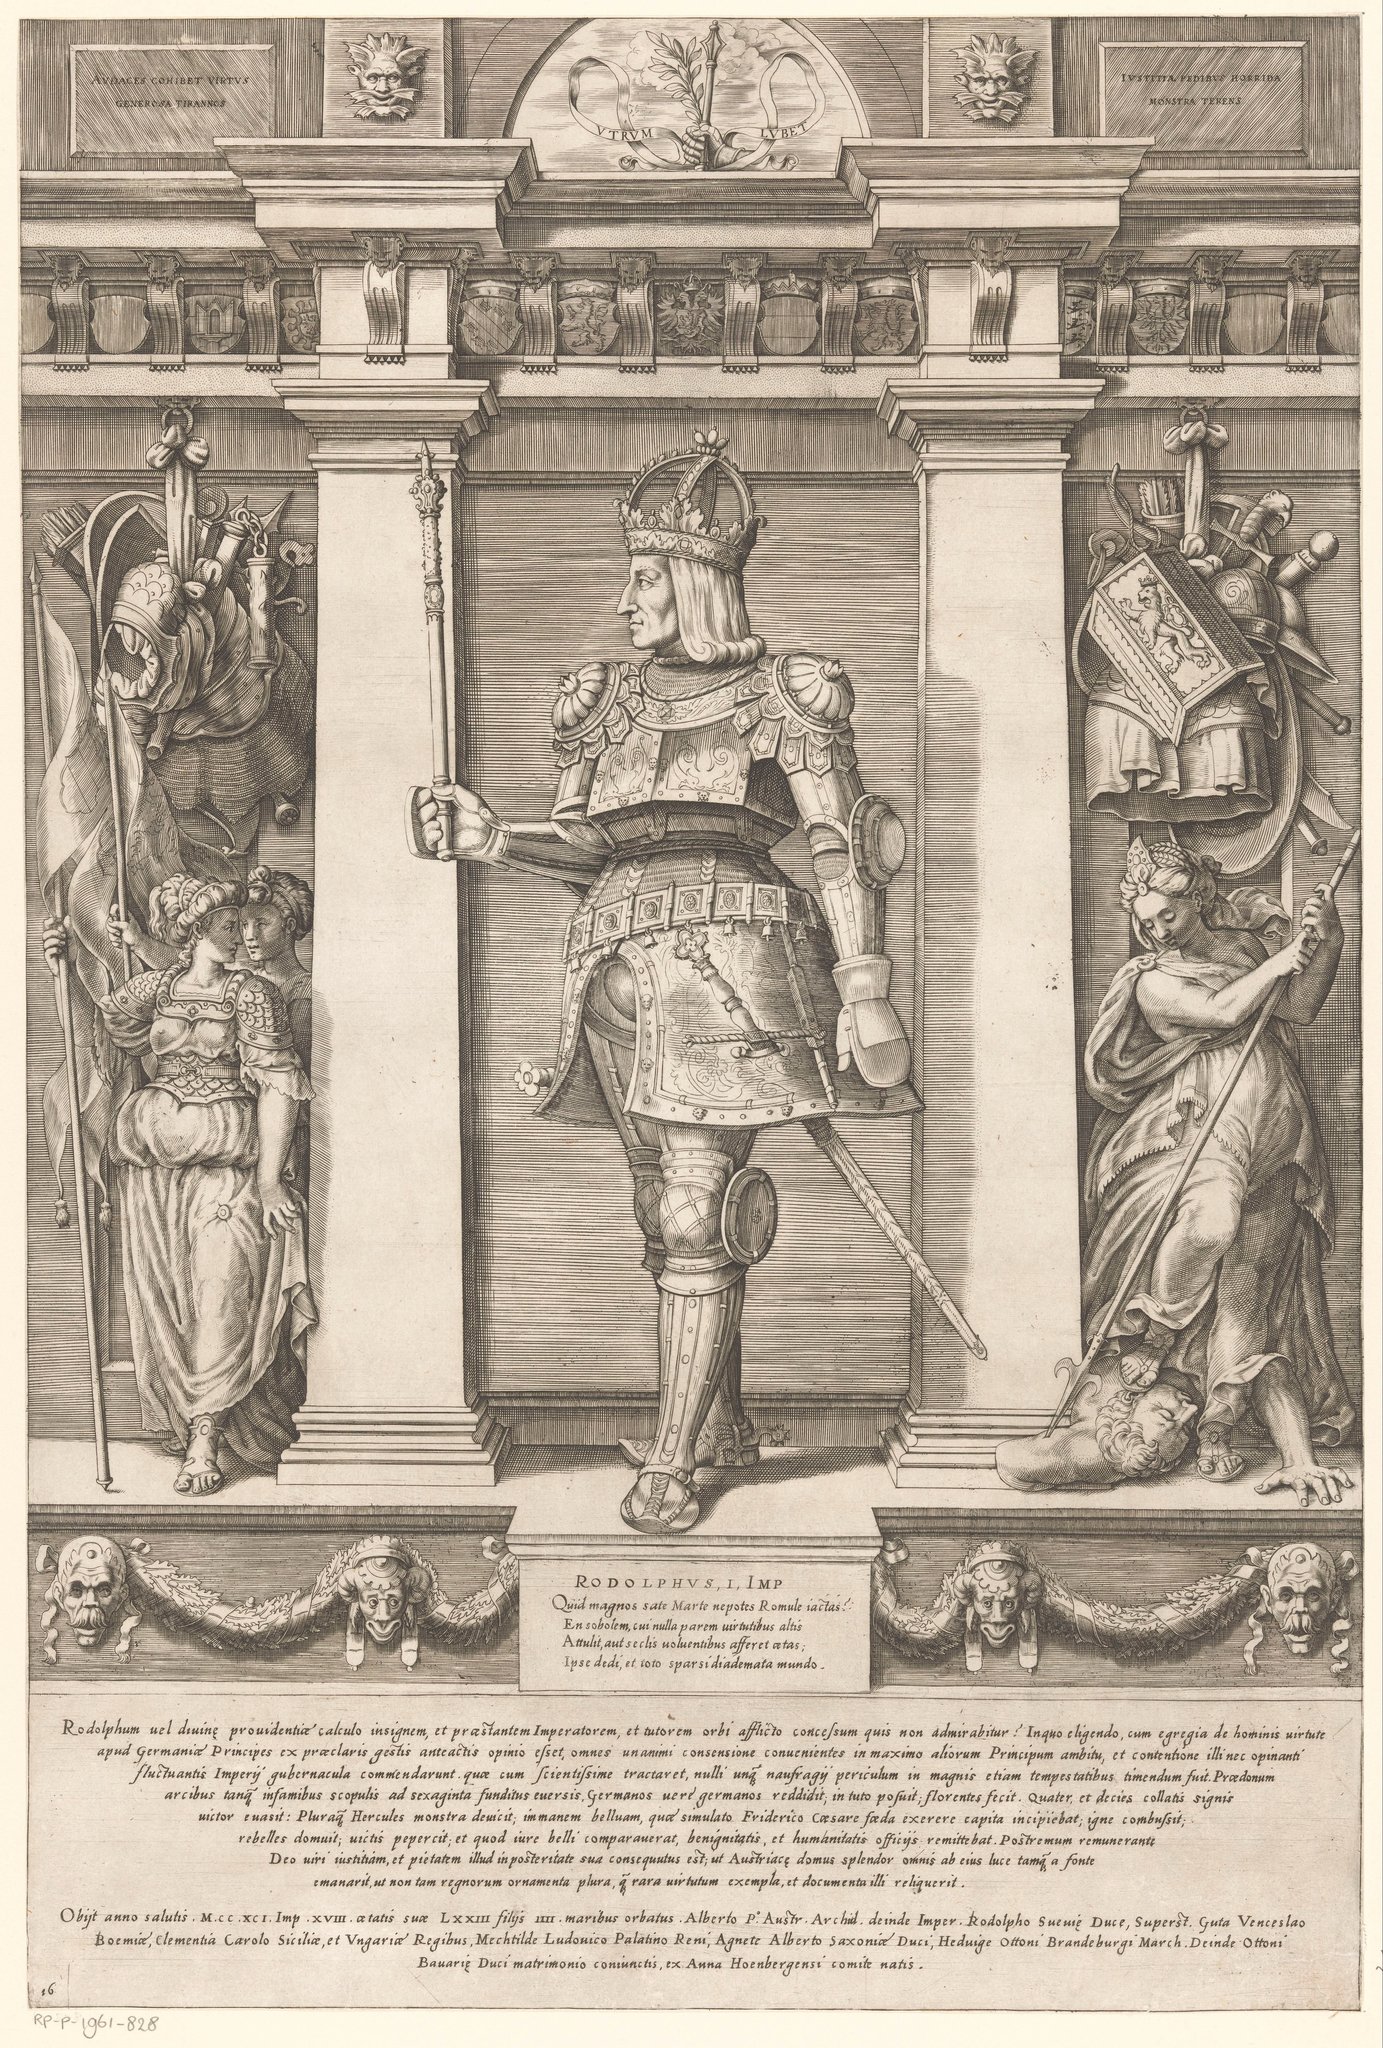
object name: print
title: Portretten van leden van het Oostenrijkse Huis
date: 1569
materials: paper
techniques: engraving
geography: italy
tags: historical persons, ruler, sovereign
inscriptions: collector's mark: Lugt 2228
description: Deze prent maakt deel uit van een reeks van 58 prenten. Het meerendeel van de prenten bevat portretten van 74 leden van het Oostenrijkse Huis, naar tekeningen door Francesco Terzio, die deels getekend zijn naar de 28 levensgrote bronzen beelden die rond de cenotaaf van Maximiliaan I in de Hofkirche te Innsbruck staan.